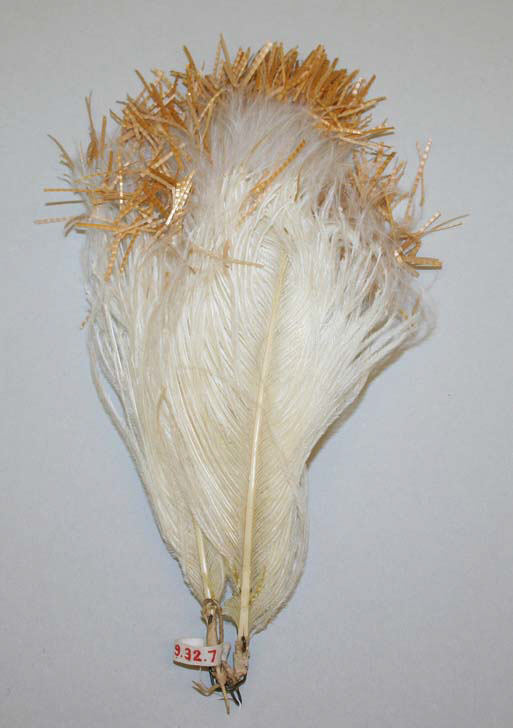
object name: headdress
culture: french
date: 1801-1900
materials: feather, fiber